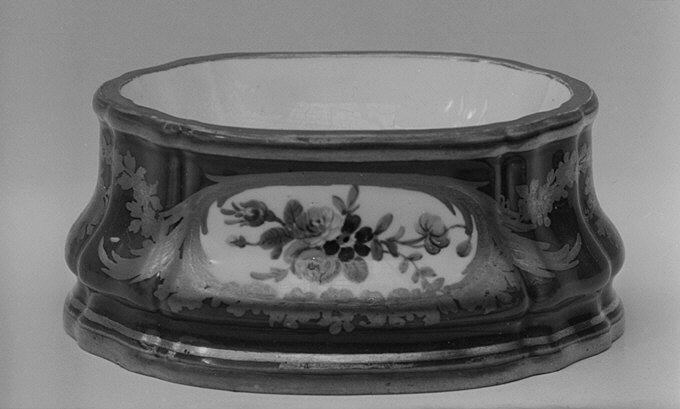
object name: salt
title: Salt (one of two) (part of a service)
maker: sèvres manufactory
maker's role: manufactory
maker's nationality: french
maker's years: 1740-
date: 1787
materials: soft paste porcelain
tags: flowers